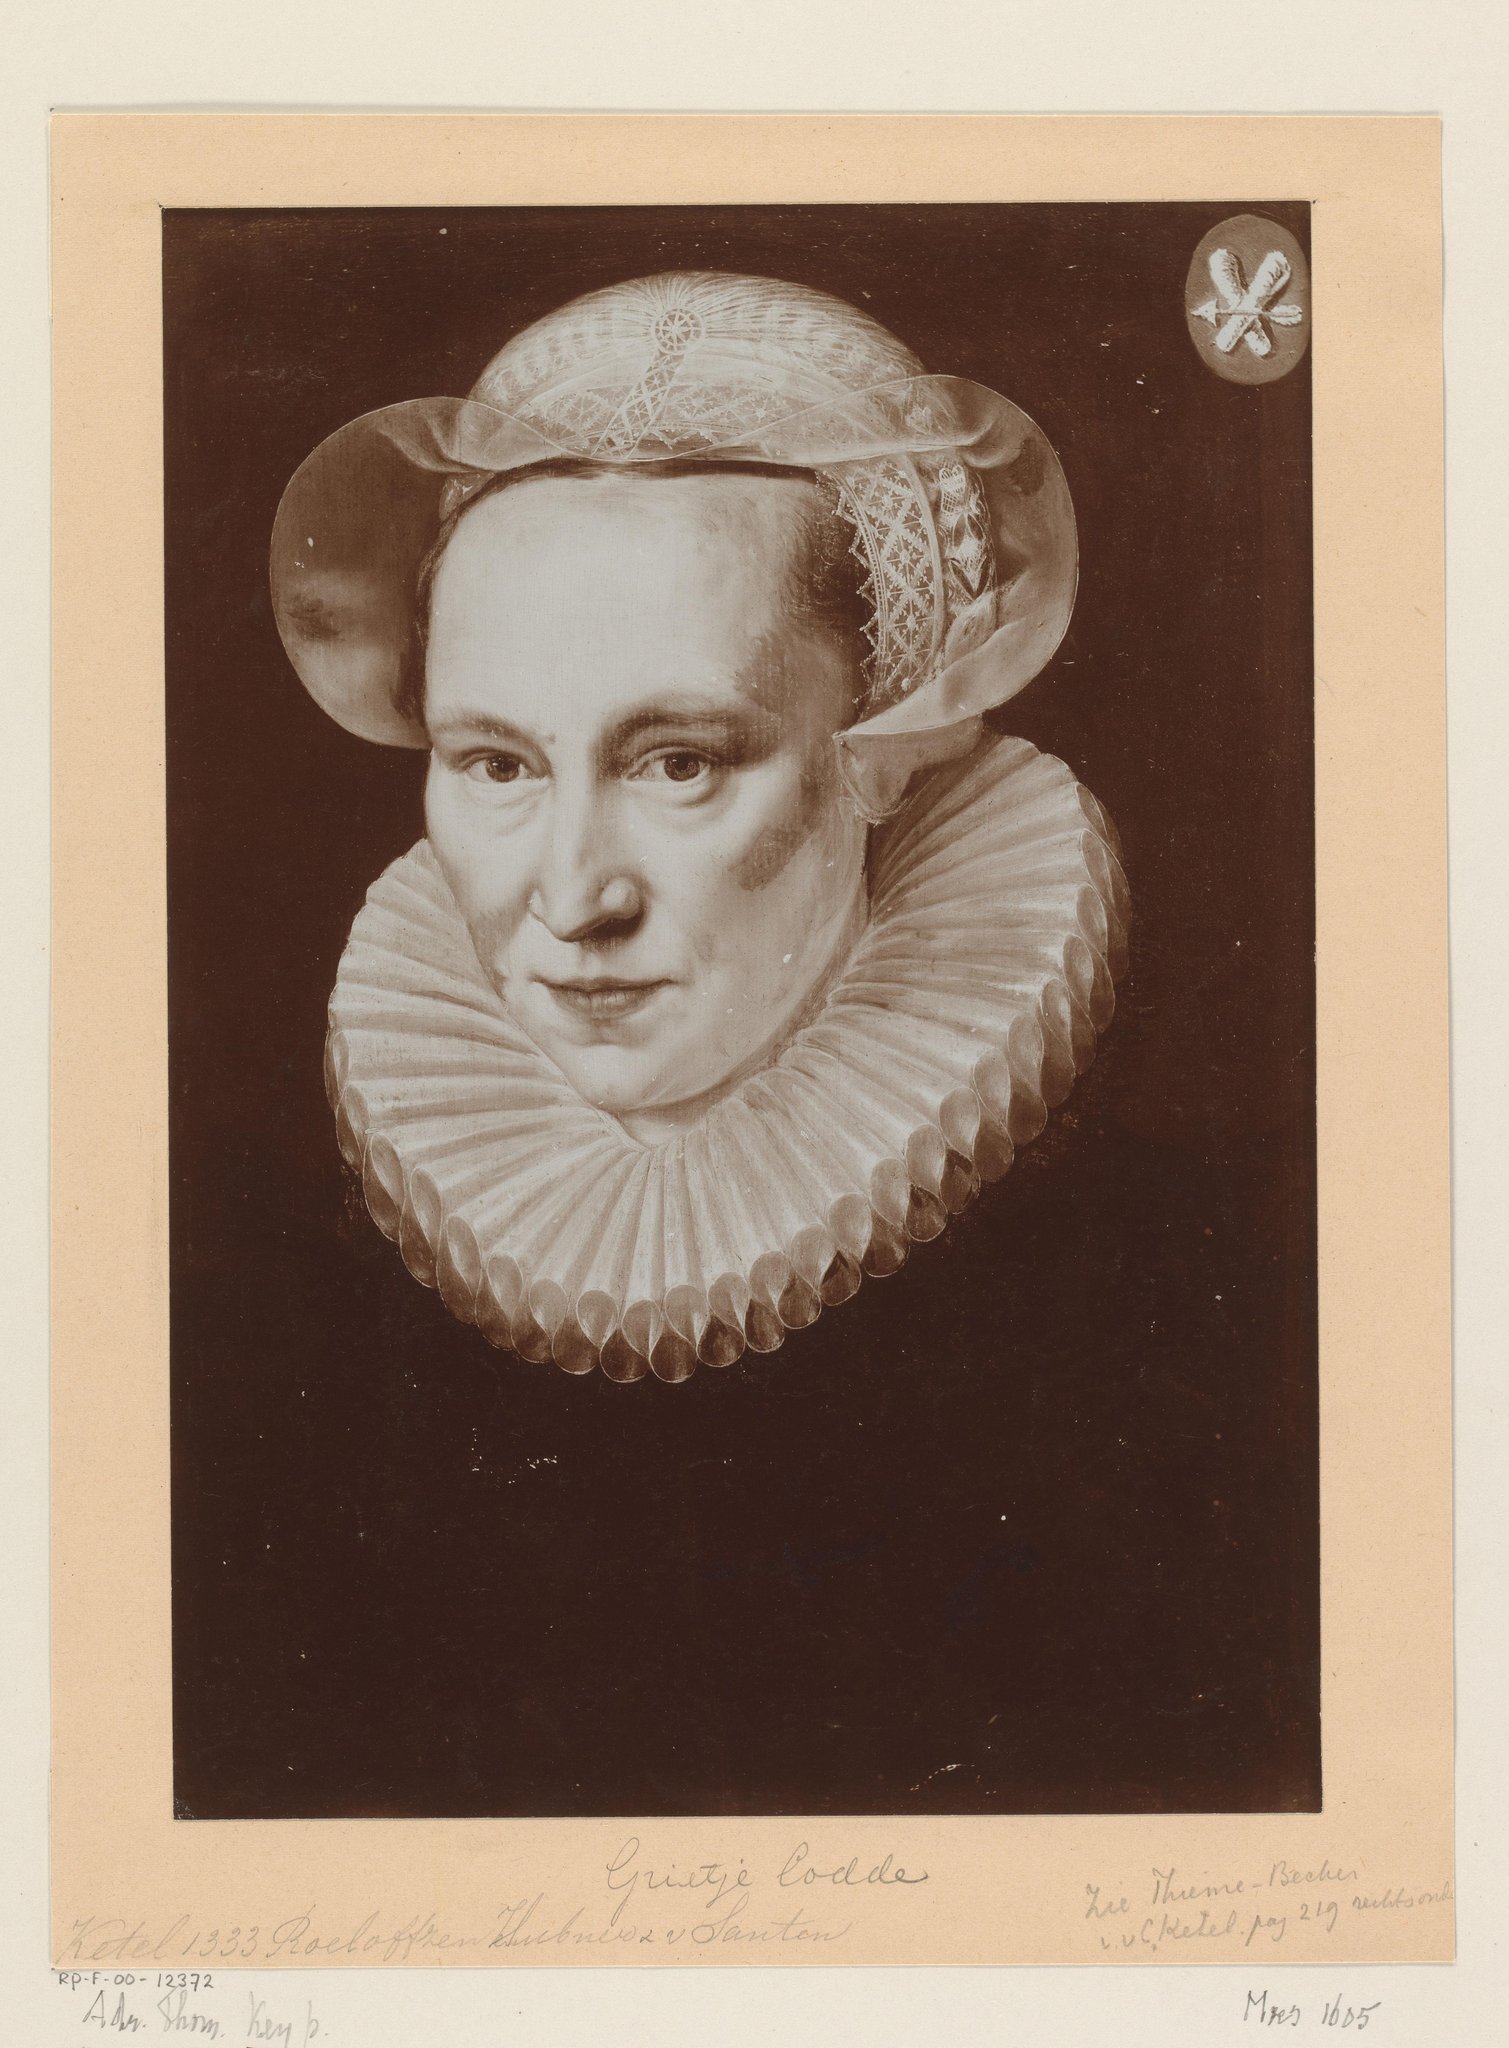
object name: photograph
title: Fotoreproductie van een geschilderd portret van Grietje Codde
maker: Anonymous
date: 1880-1910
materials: paper, cardboard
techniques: collodion silver print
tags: historical persons - bb - woman, picture, painting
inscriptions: collector's mark: Lugt 2228, inscription: ‘Grietje Codde/ Ketel 1333 Roeloffzen Hubner v Santen/ Zie Thieme-Becker/ vvC Ketel, pag 219 rechtsonder’